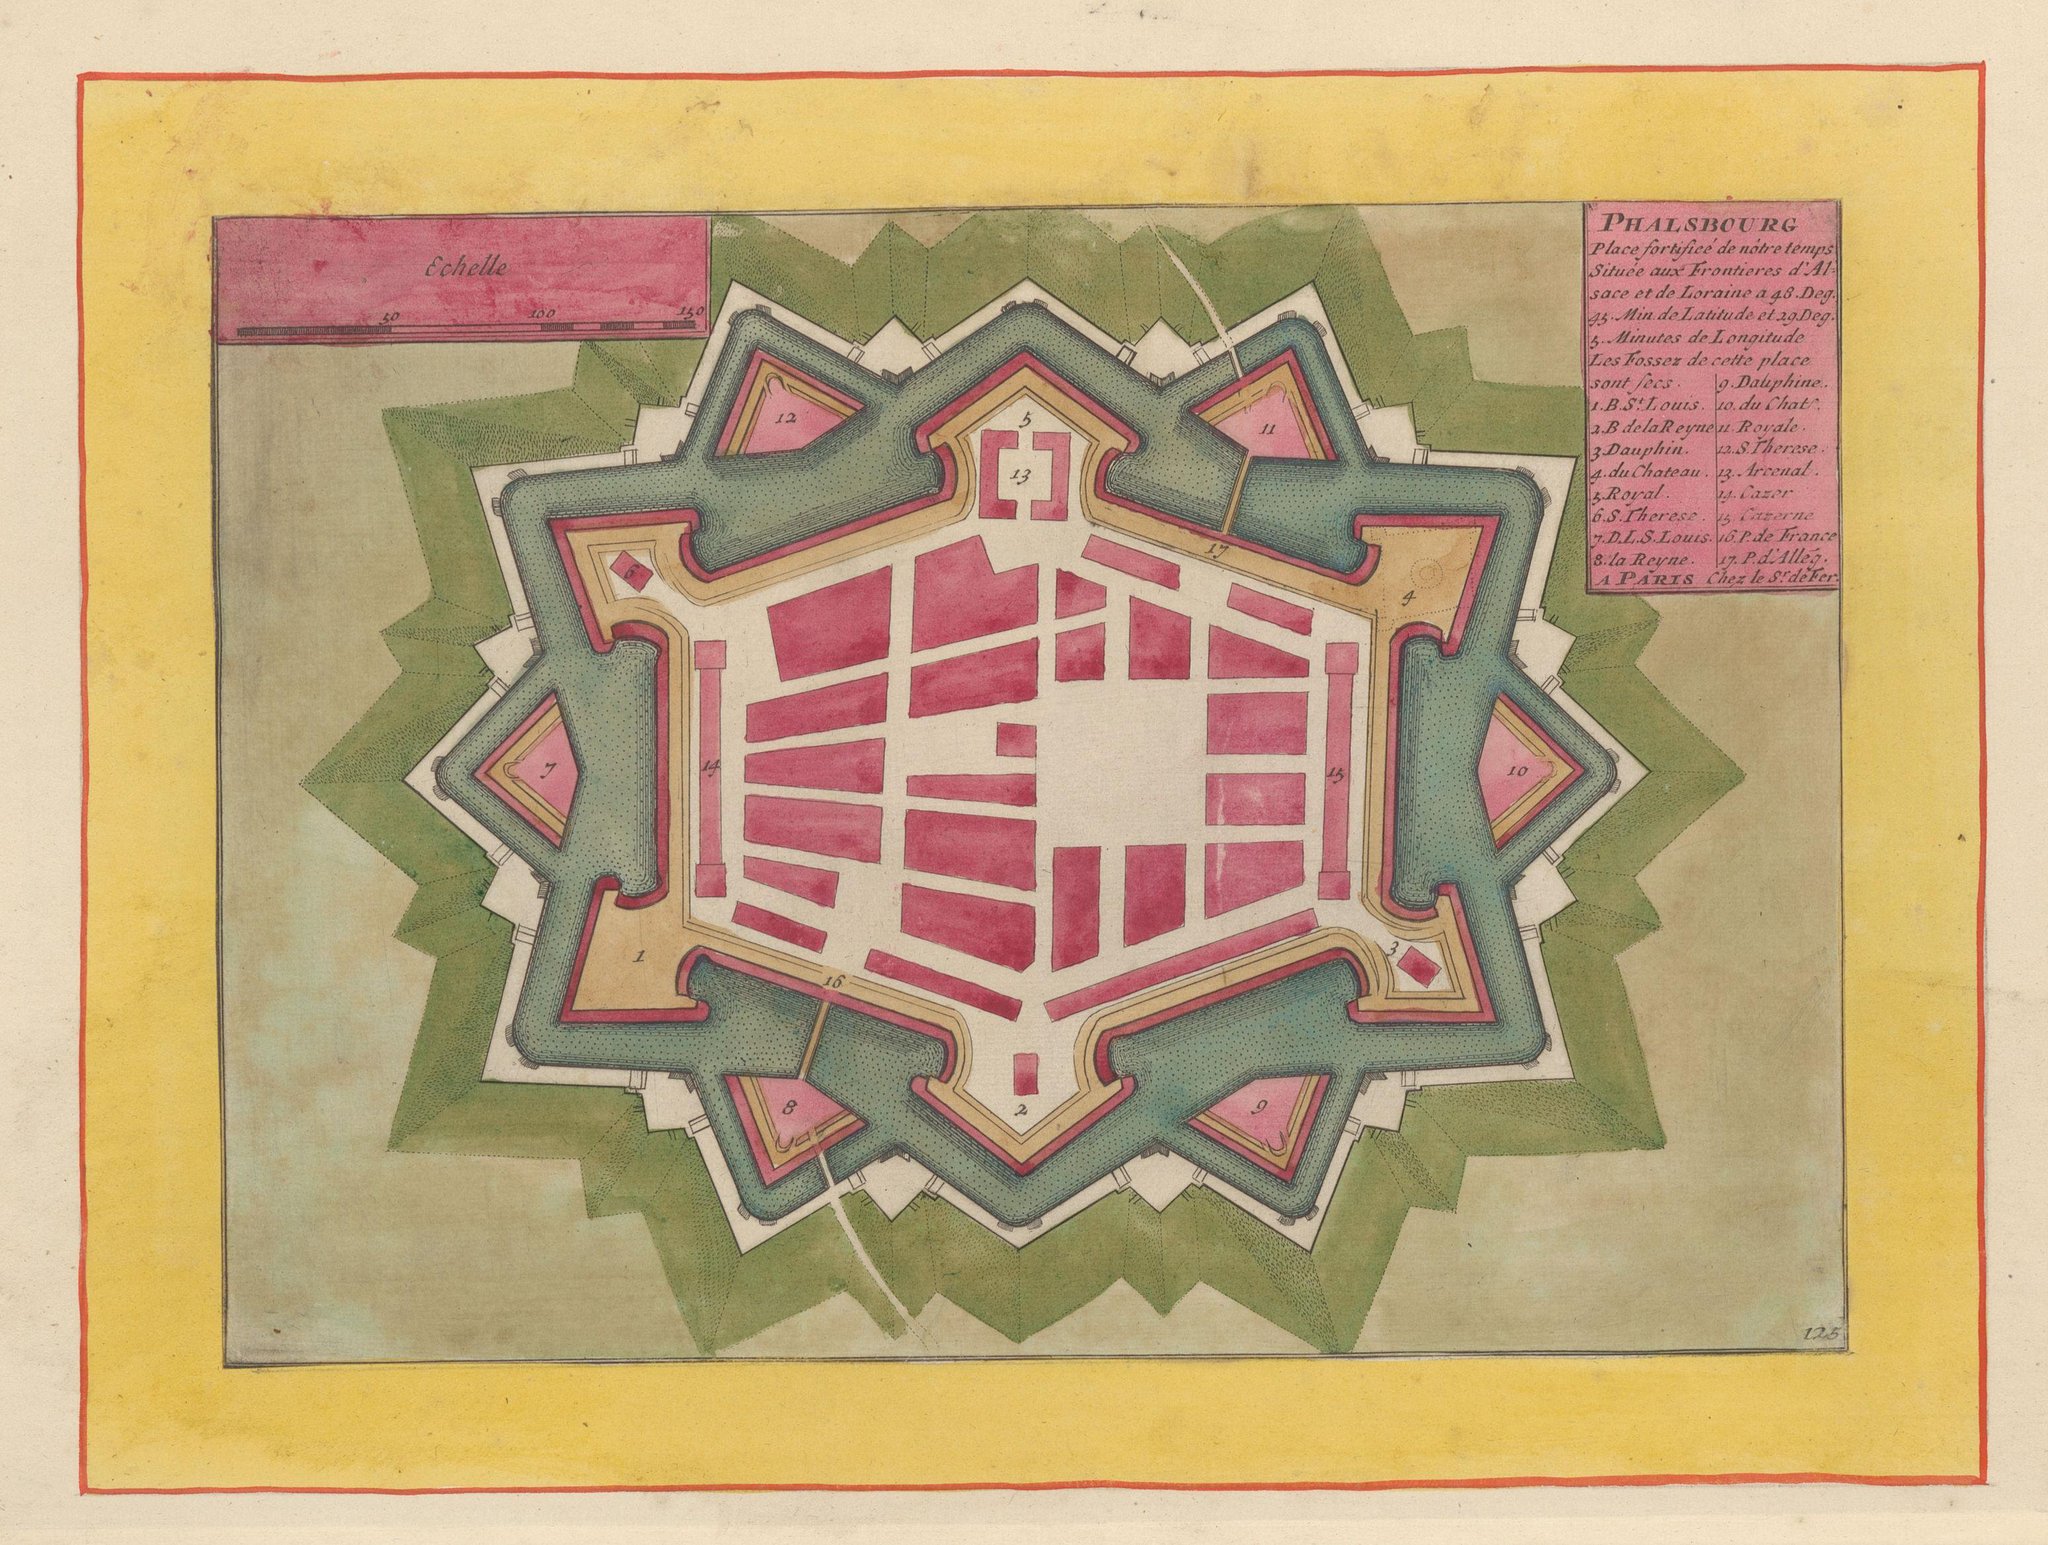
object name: album leaf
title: Phalsbourg place fortifieé de notre temps située aux frontieres d'Alsace et de Loraine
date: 1702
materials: paper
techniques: engraving, hand coloring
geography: amsterdam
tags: maps of cities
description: Plattegrond uit: Les forces de l'Europe, Asie, Afrique et Amerique. 12 dln. Amsterdam: Pieter Mortier, 1702.